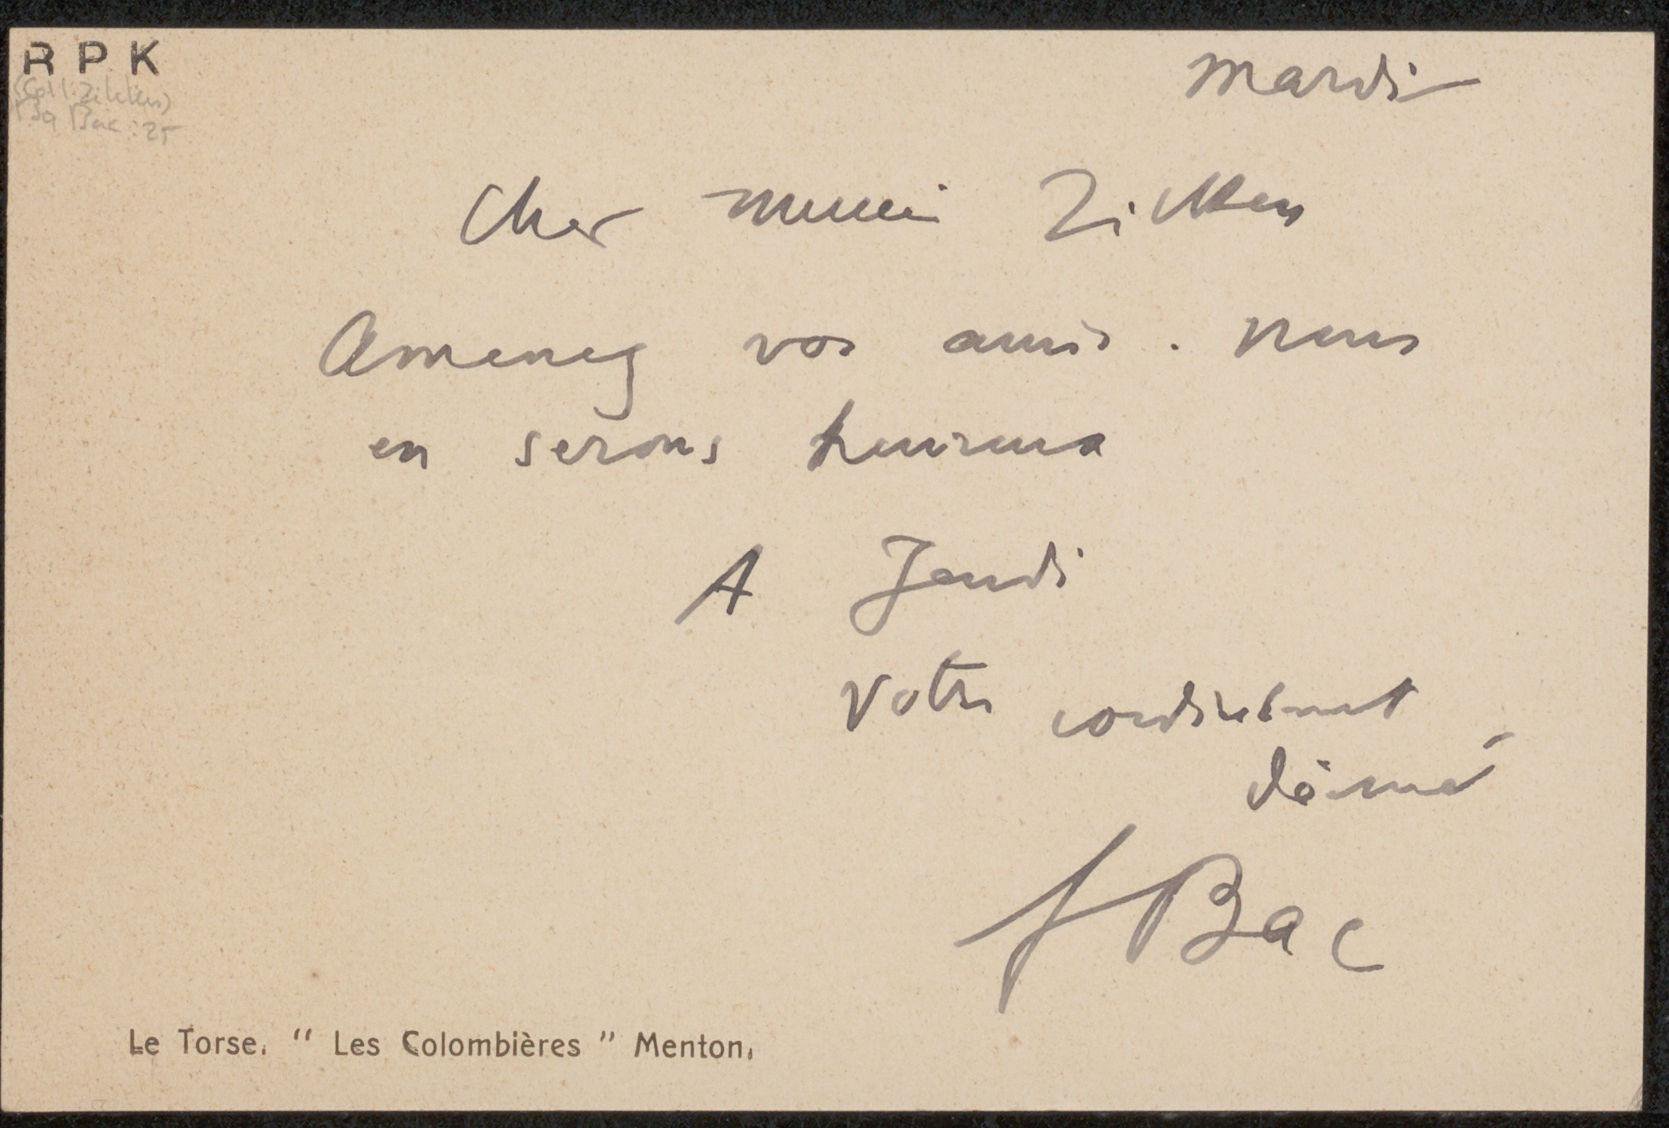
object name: ansichtkaart, prentbriefkaart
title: Prentbriefkaart aan Philip Zilcken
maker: ferdinand-sigismund bac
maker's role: draughtsman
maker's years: 1859-1952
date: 1928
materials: cardboard, ink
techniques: pen, printing, writing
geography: menton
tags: the hague, painter, philip zilcken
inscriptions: collector's mark: ‘RPK’